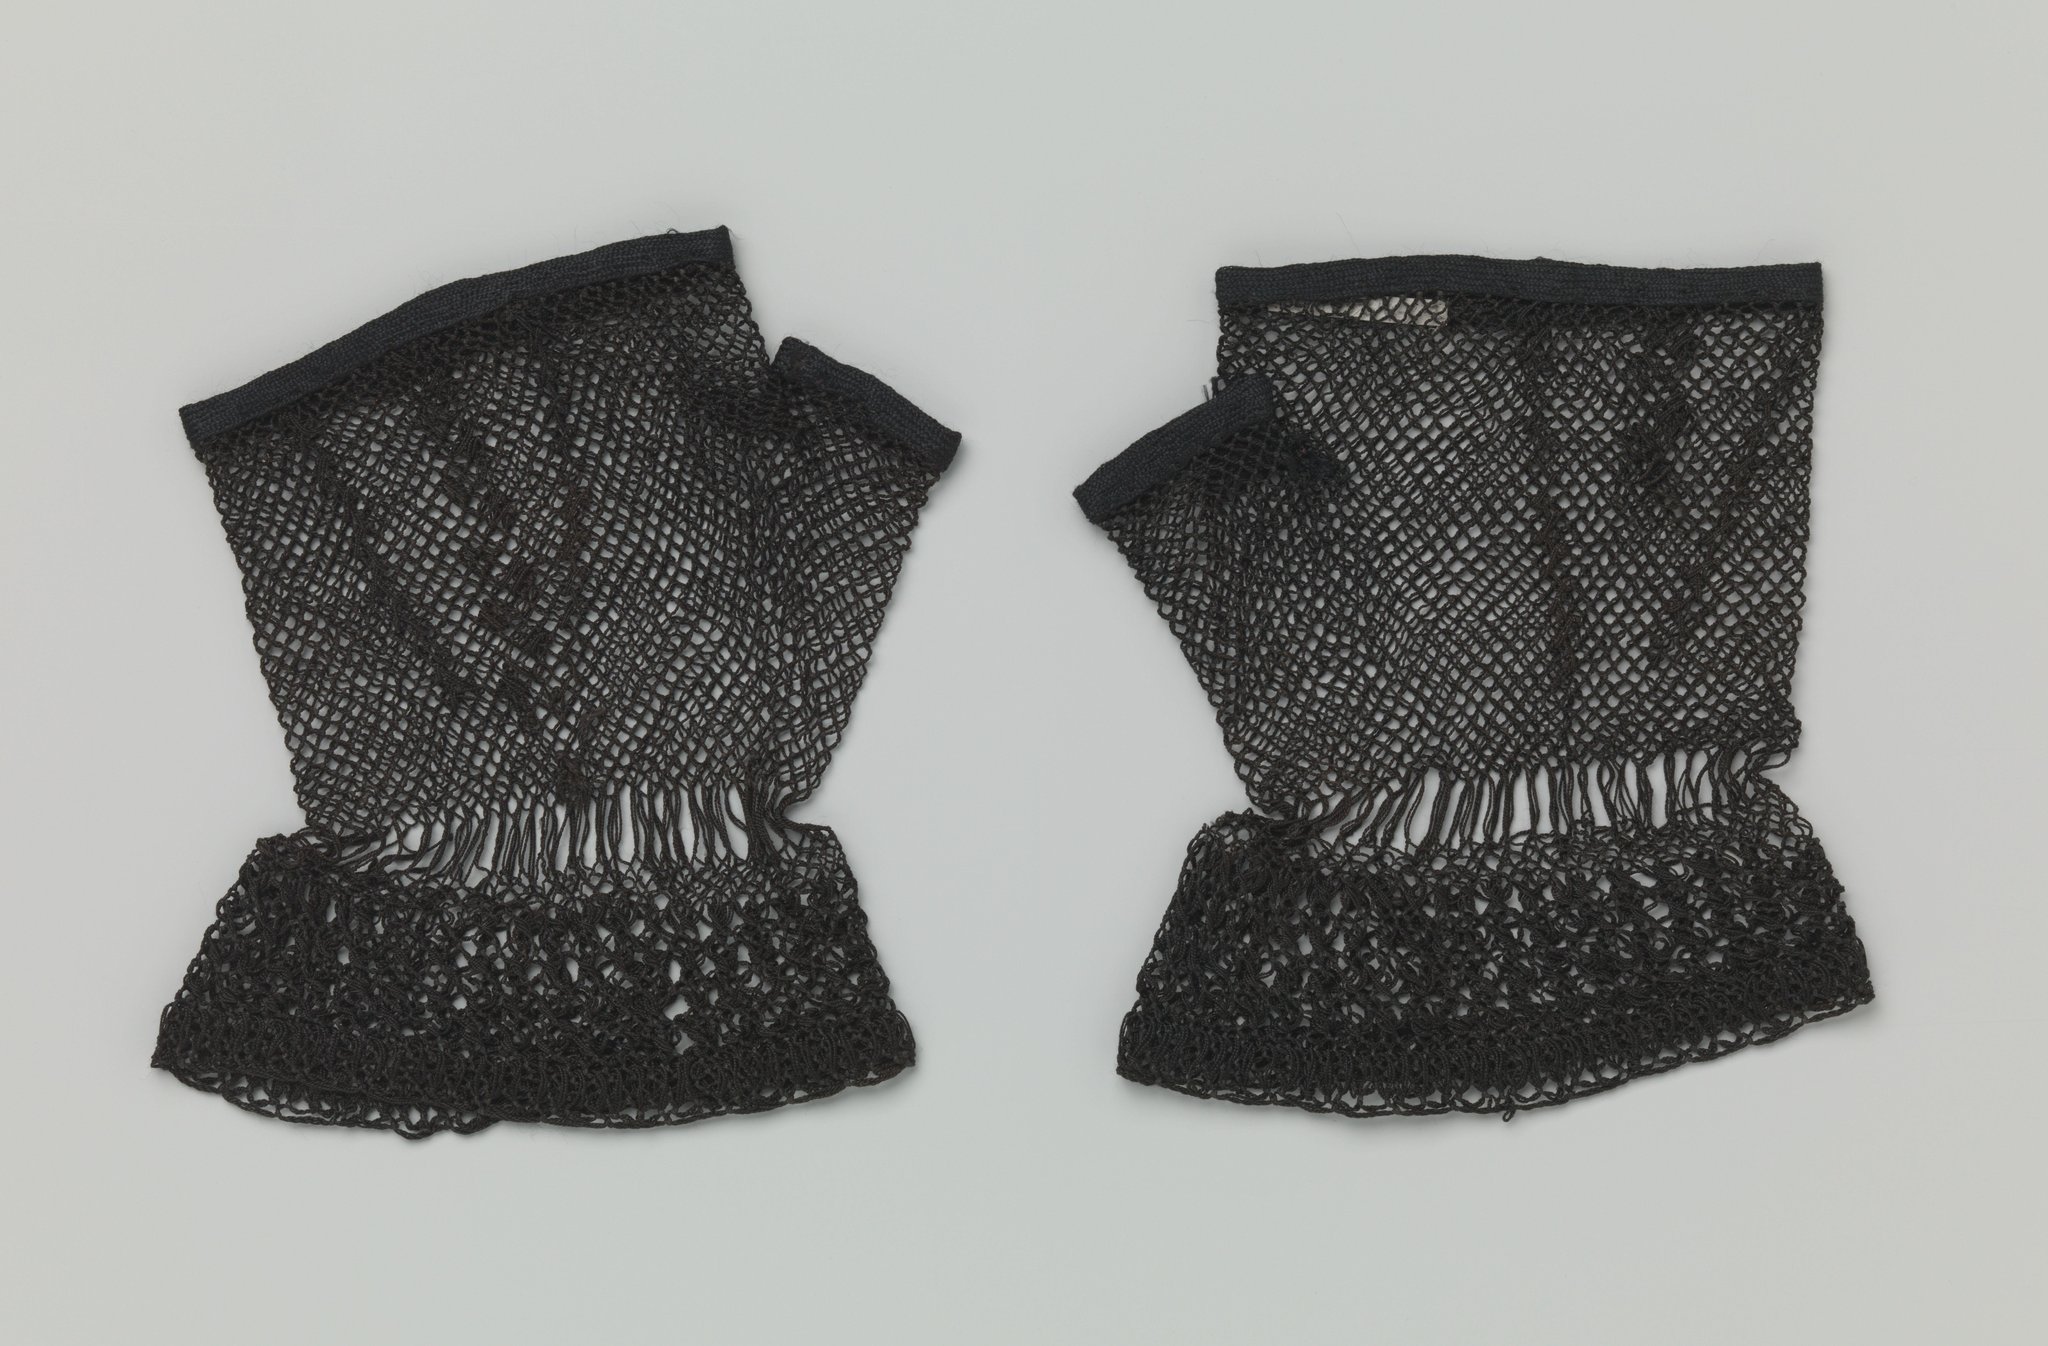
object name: clothing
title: Mitaine van zwarte katoen in Egyptisch vlechtwerk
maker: Anonymous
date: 1900-1925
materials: cotton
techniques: sprang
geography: netherlands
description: Mitaine van zwarte katoen in Egyptisch vlechtwerk.